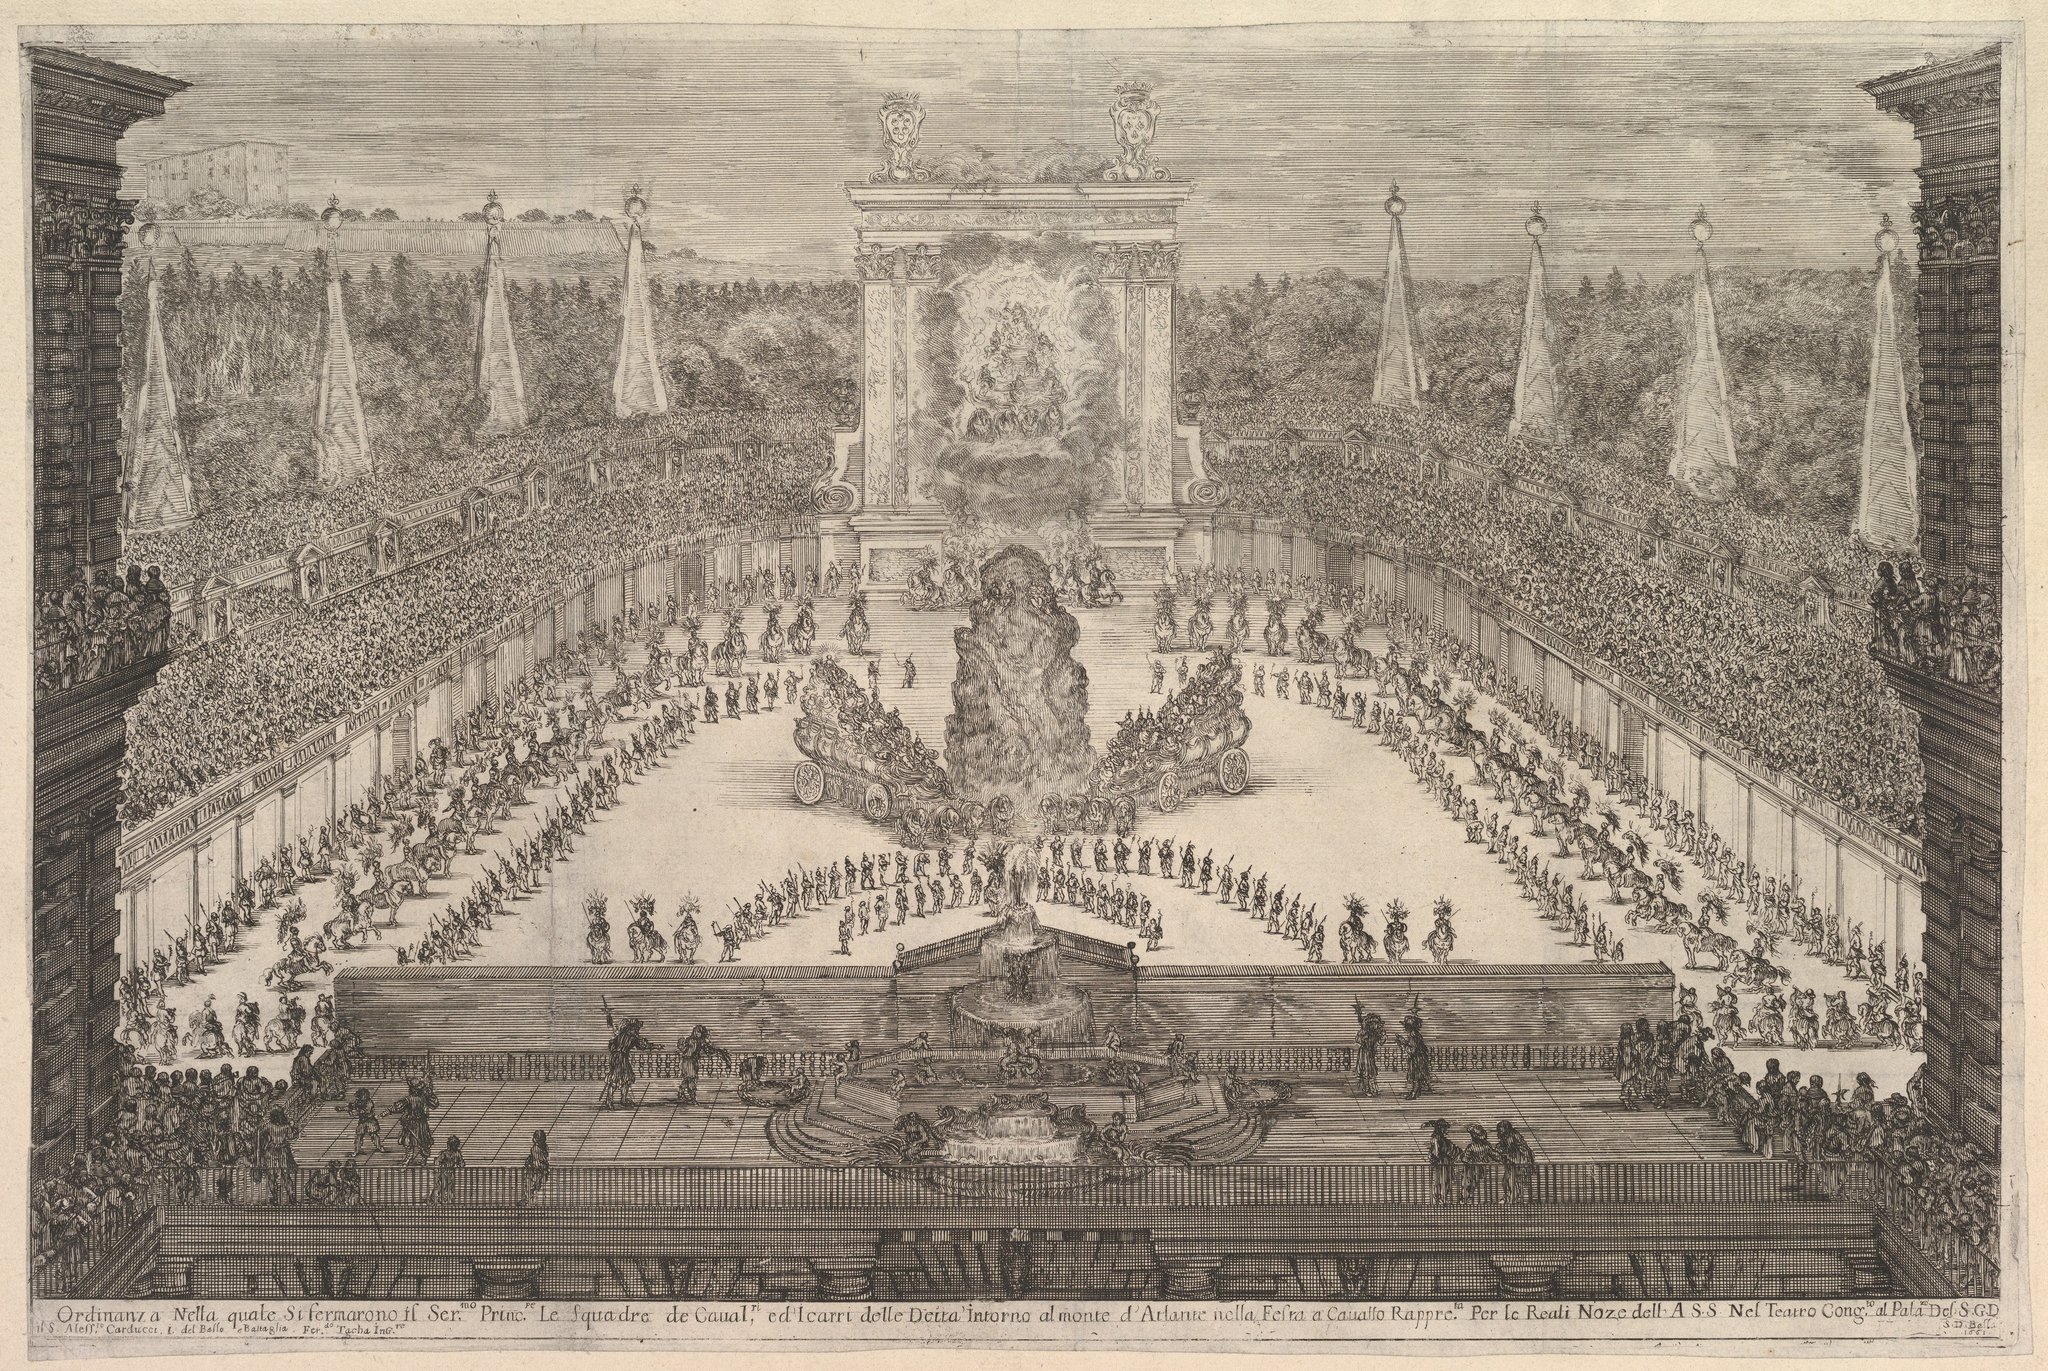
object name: print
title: The Prince of Tuscany and his chariots arranged around Mount Atlas in center, from "Il mondo festeggiante"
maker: stefano della bella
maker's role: artist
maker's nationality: italian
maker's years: 1610-1664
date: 1661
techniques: etching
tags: fountains,spectators,coat of arms,chariots